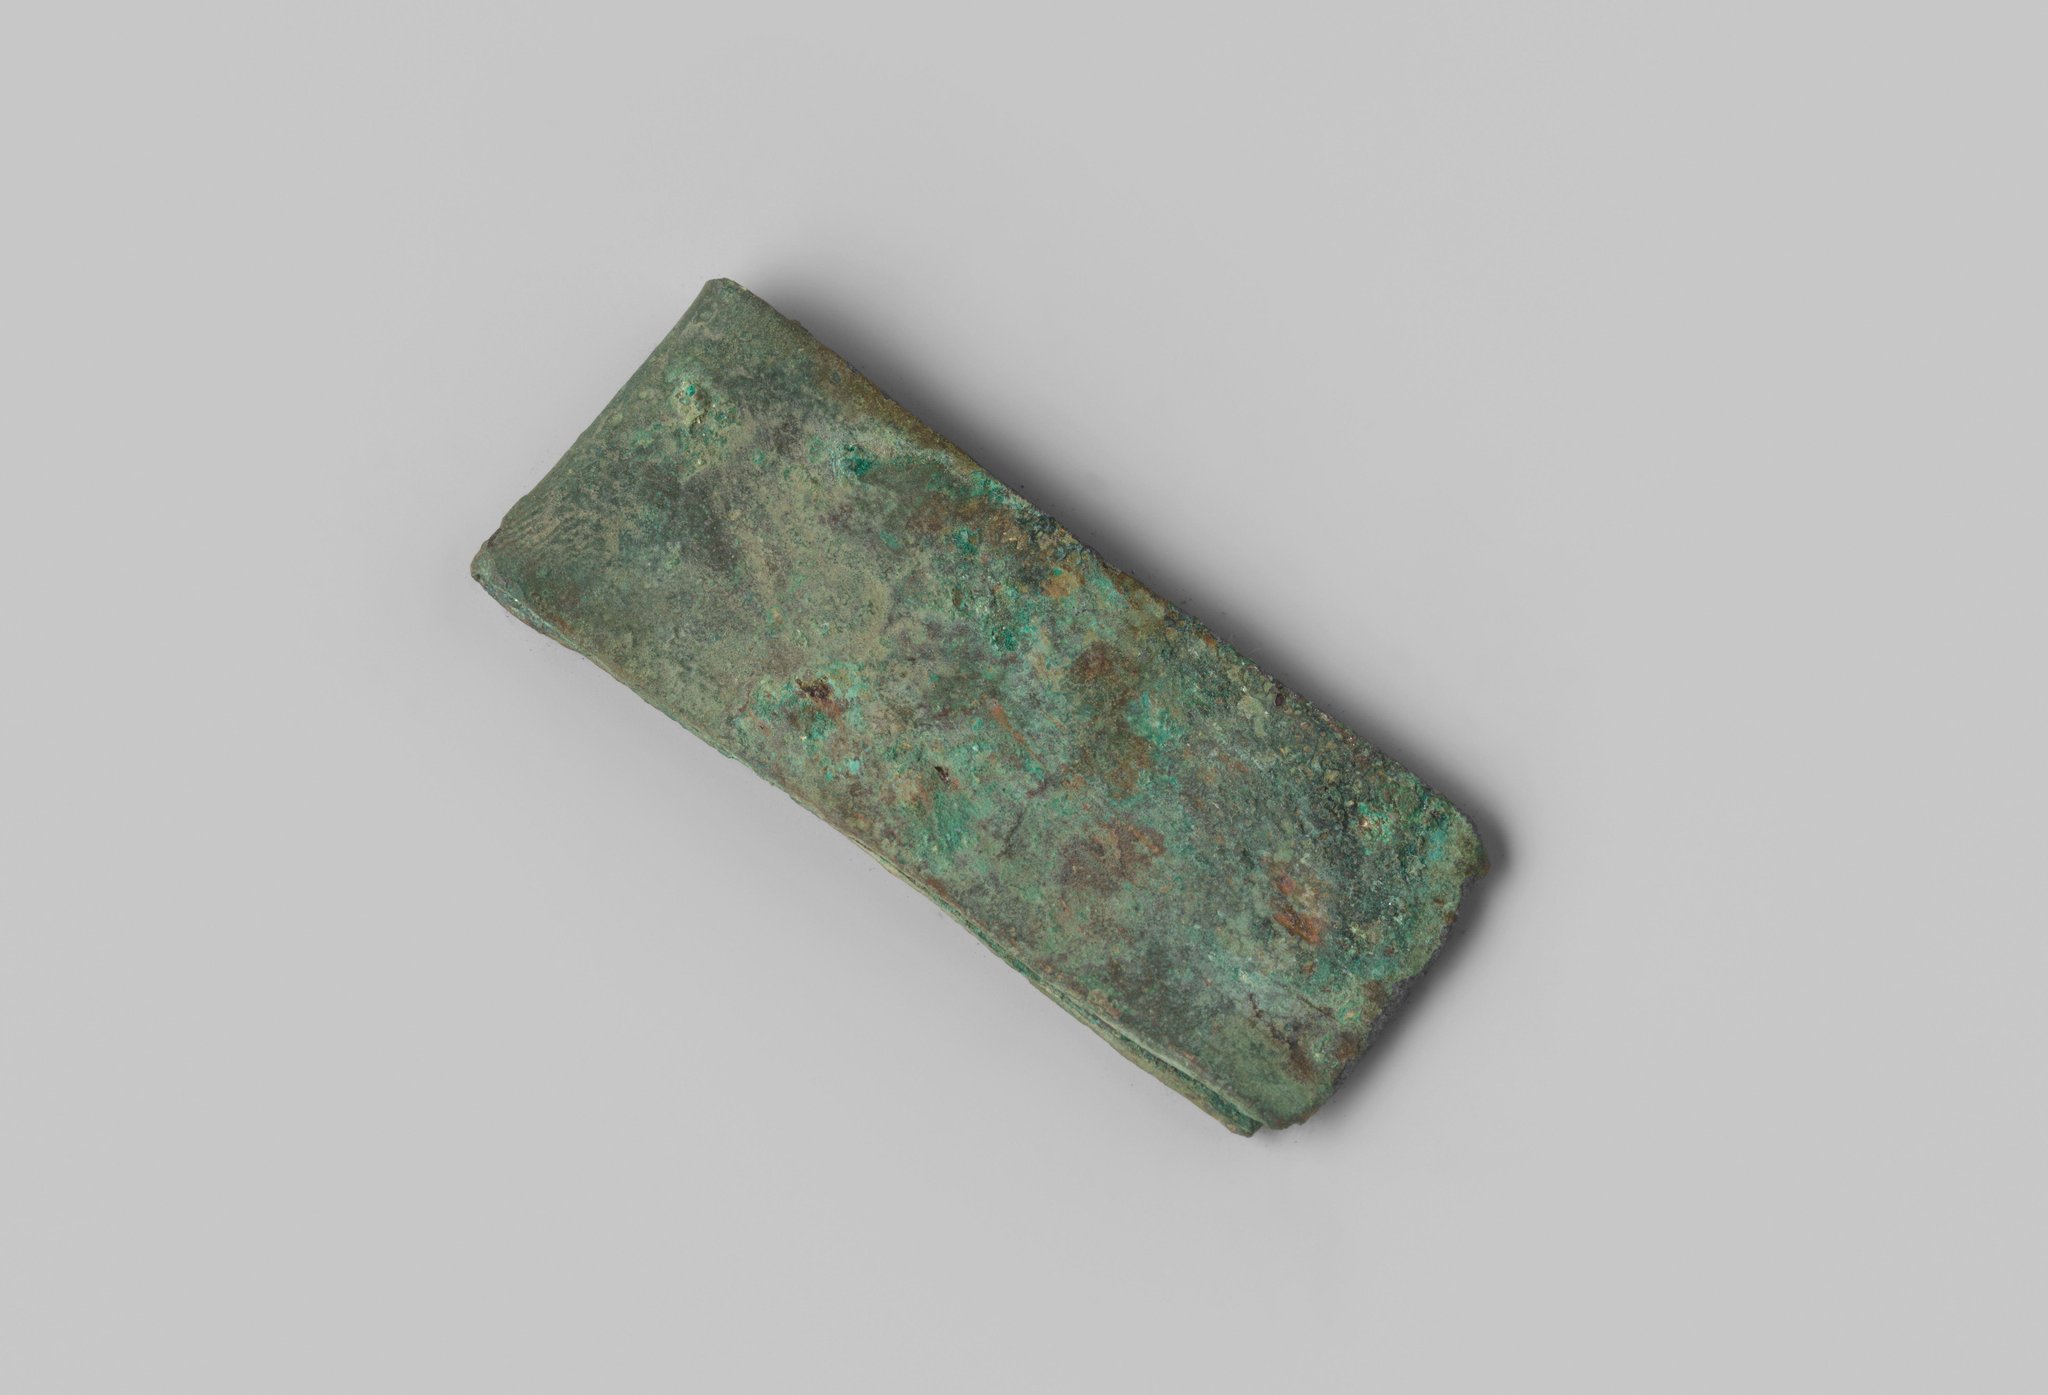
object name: firehose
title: Brandslangring uit het wrak van de Oost-Indiëvaarder Hollandia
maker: Anonymous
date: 1700-1743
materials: copper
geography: netherlands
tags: verenigde oostindische compagnie, hollandia (schip), annet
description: Firehose, fragm, id. NG 1975-20H1271a, squashed.